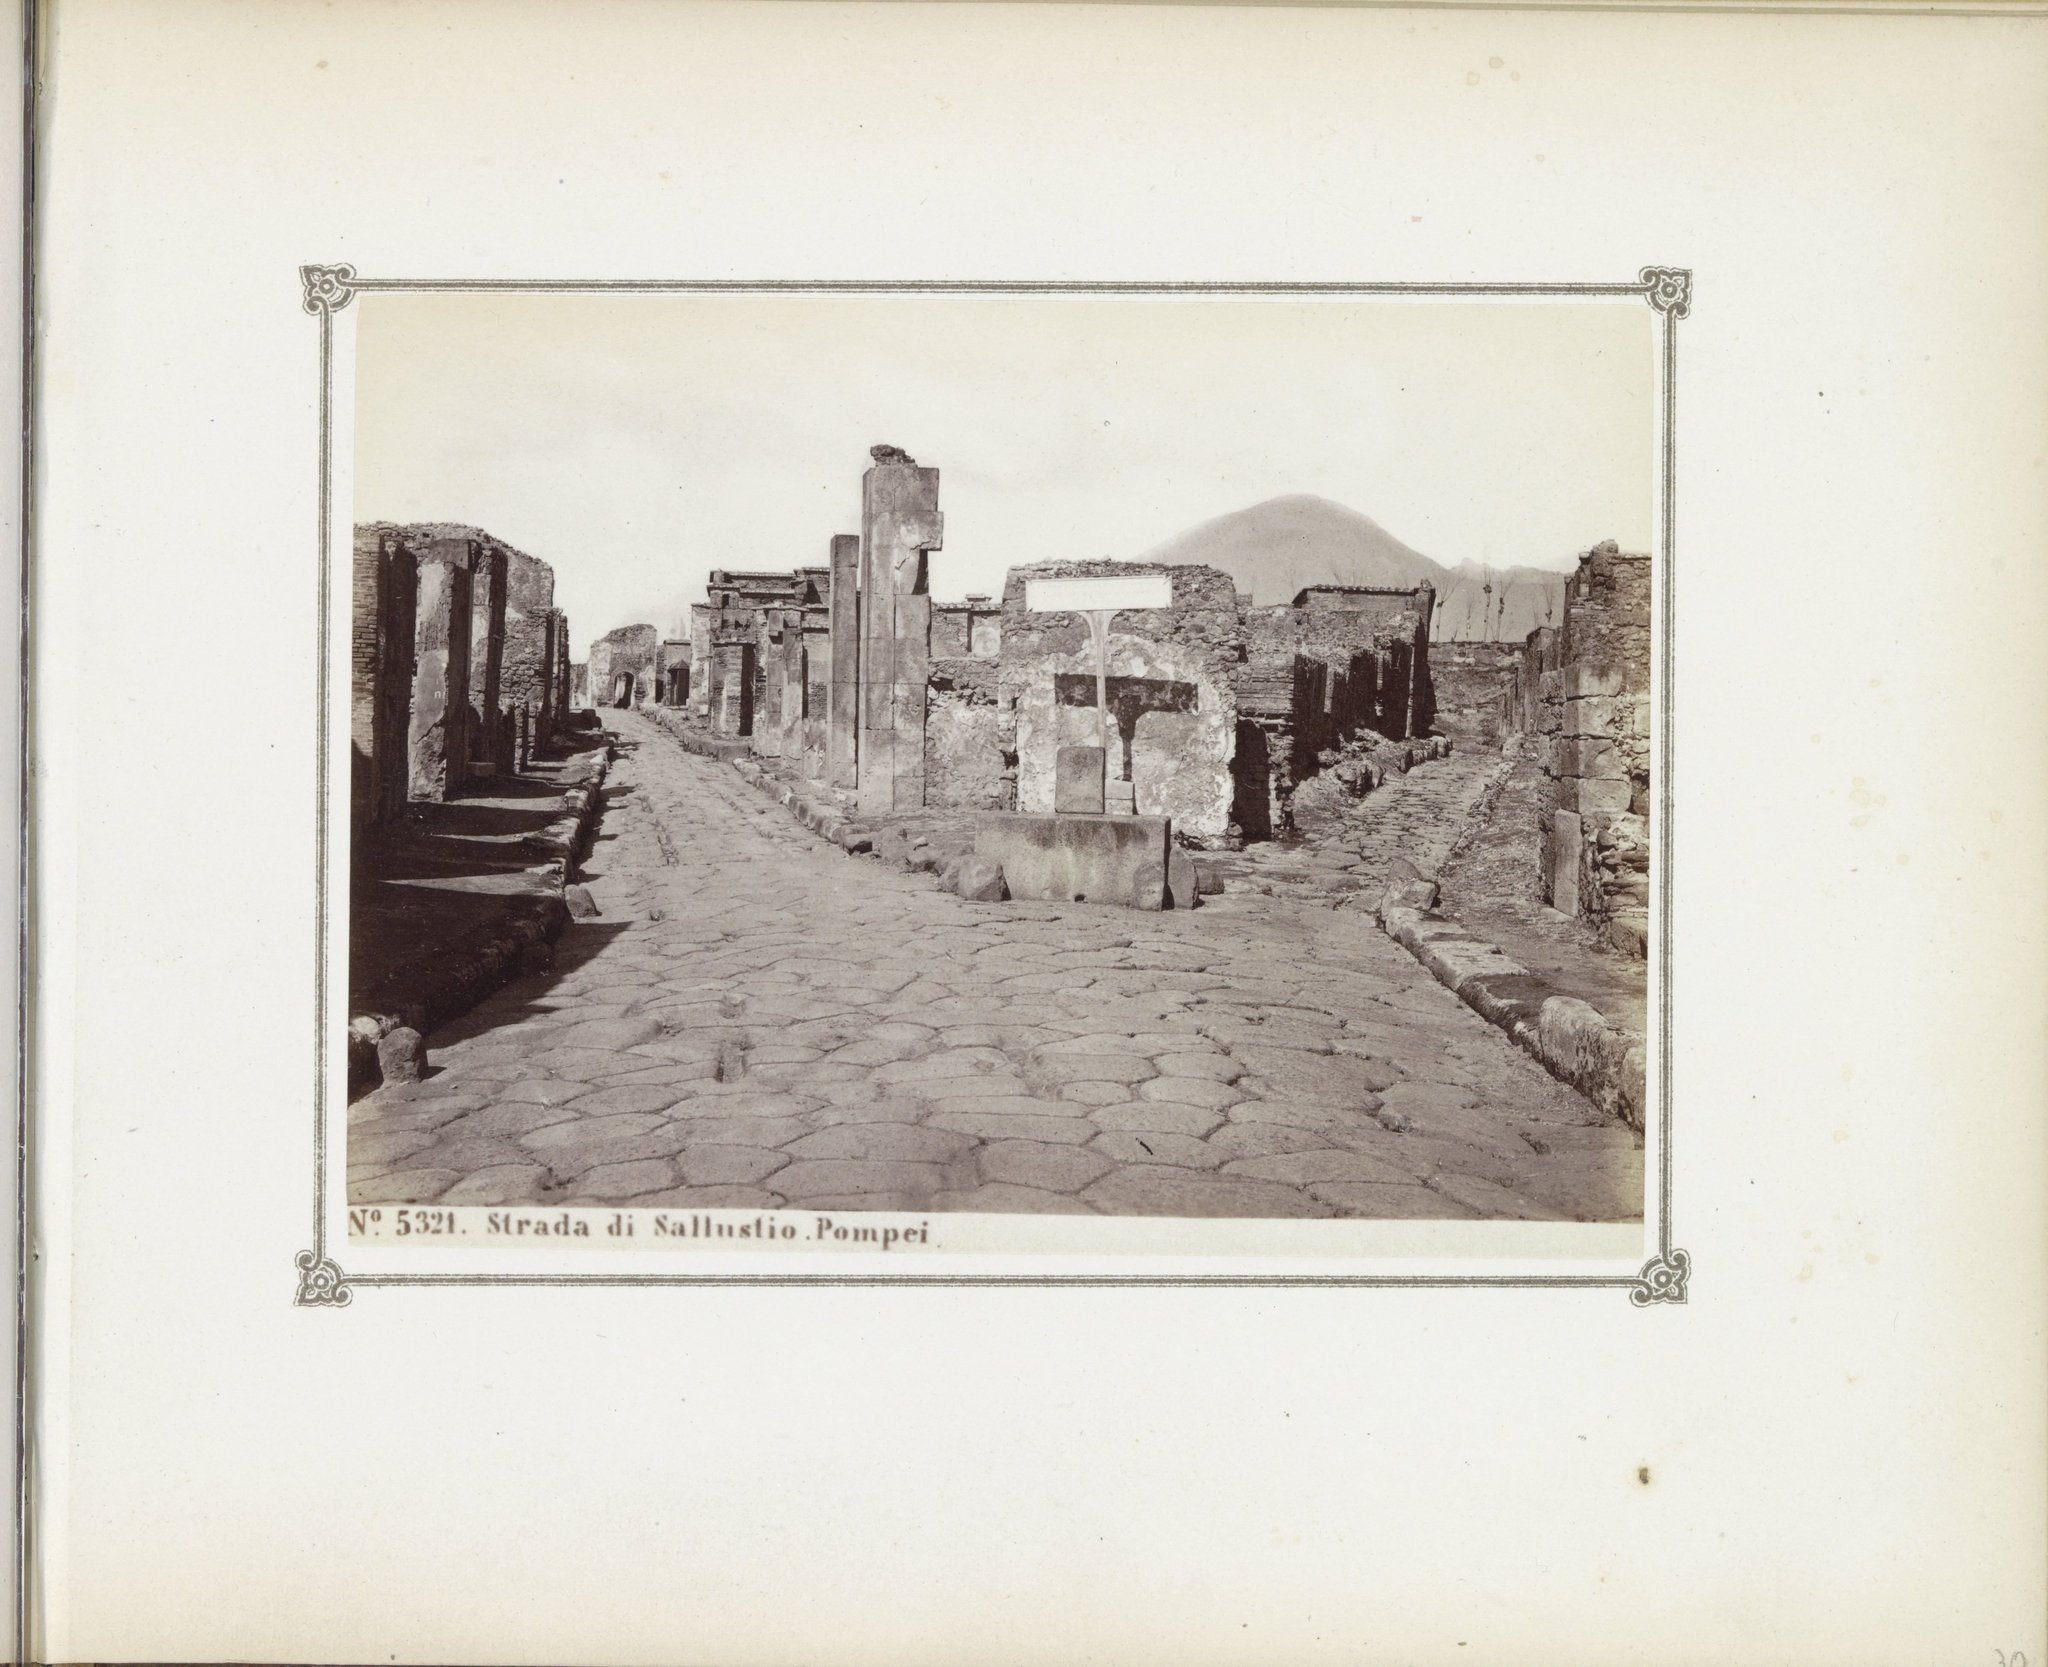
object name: album leaf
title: Restanten van de Straat van Sallustius in Pompeï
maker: giorgio sommer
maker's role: fotograaf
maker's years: 1834-1914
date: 1860-1900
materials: paper, photographic support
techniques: albumen print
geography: pompeii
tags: excavation ~ archaeology, street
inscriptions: number: ‘5321’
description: Onderdeel van Fotoalbum met opnames van opgravingen in Pompeï door Giorgio Sommer.